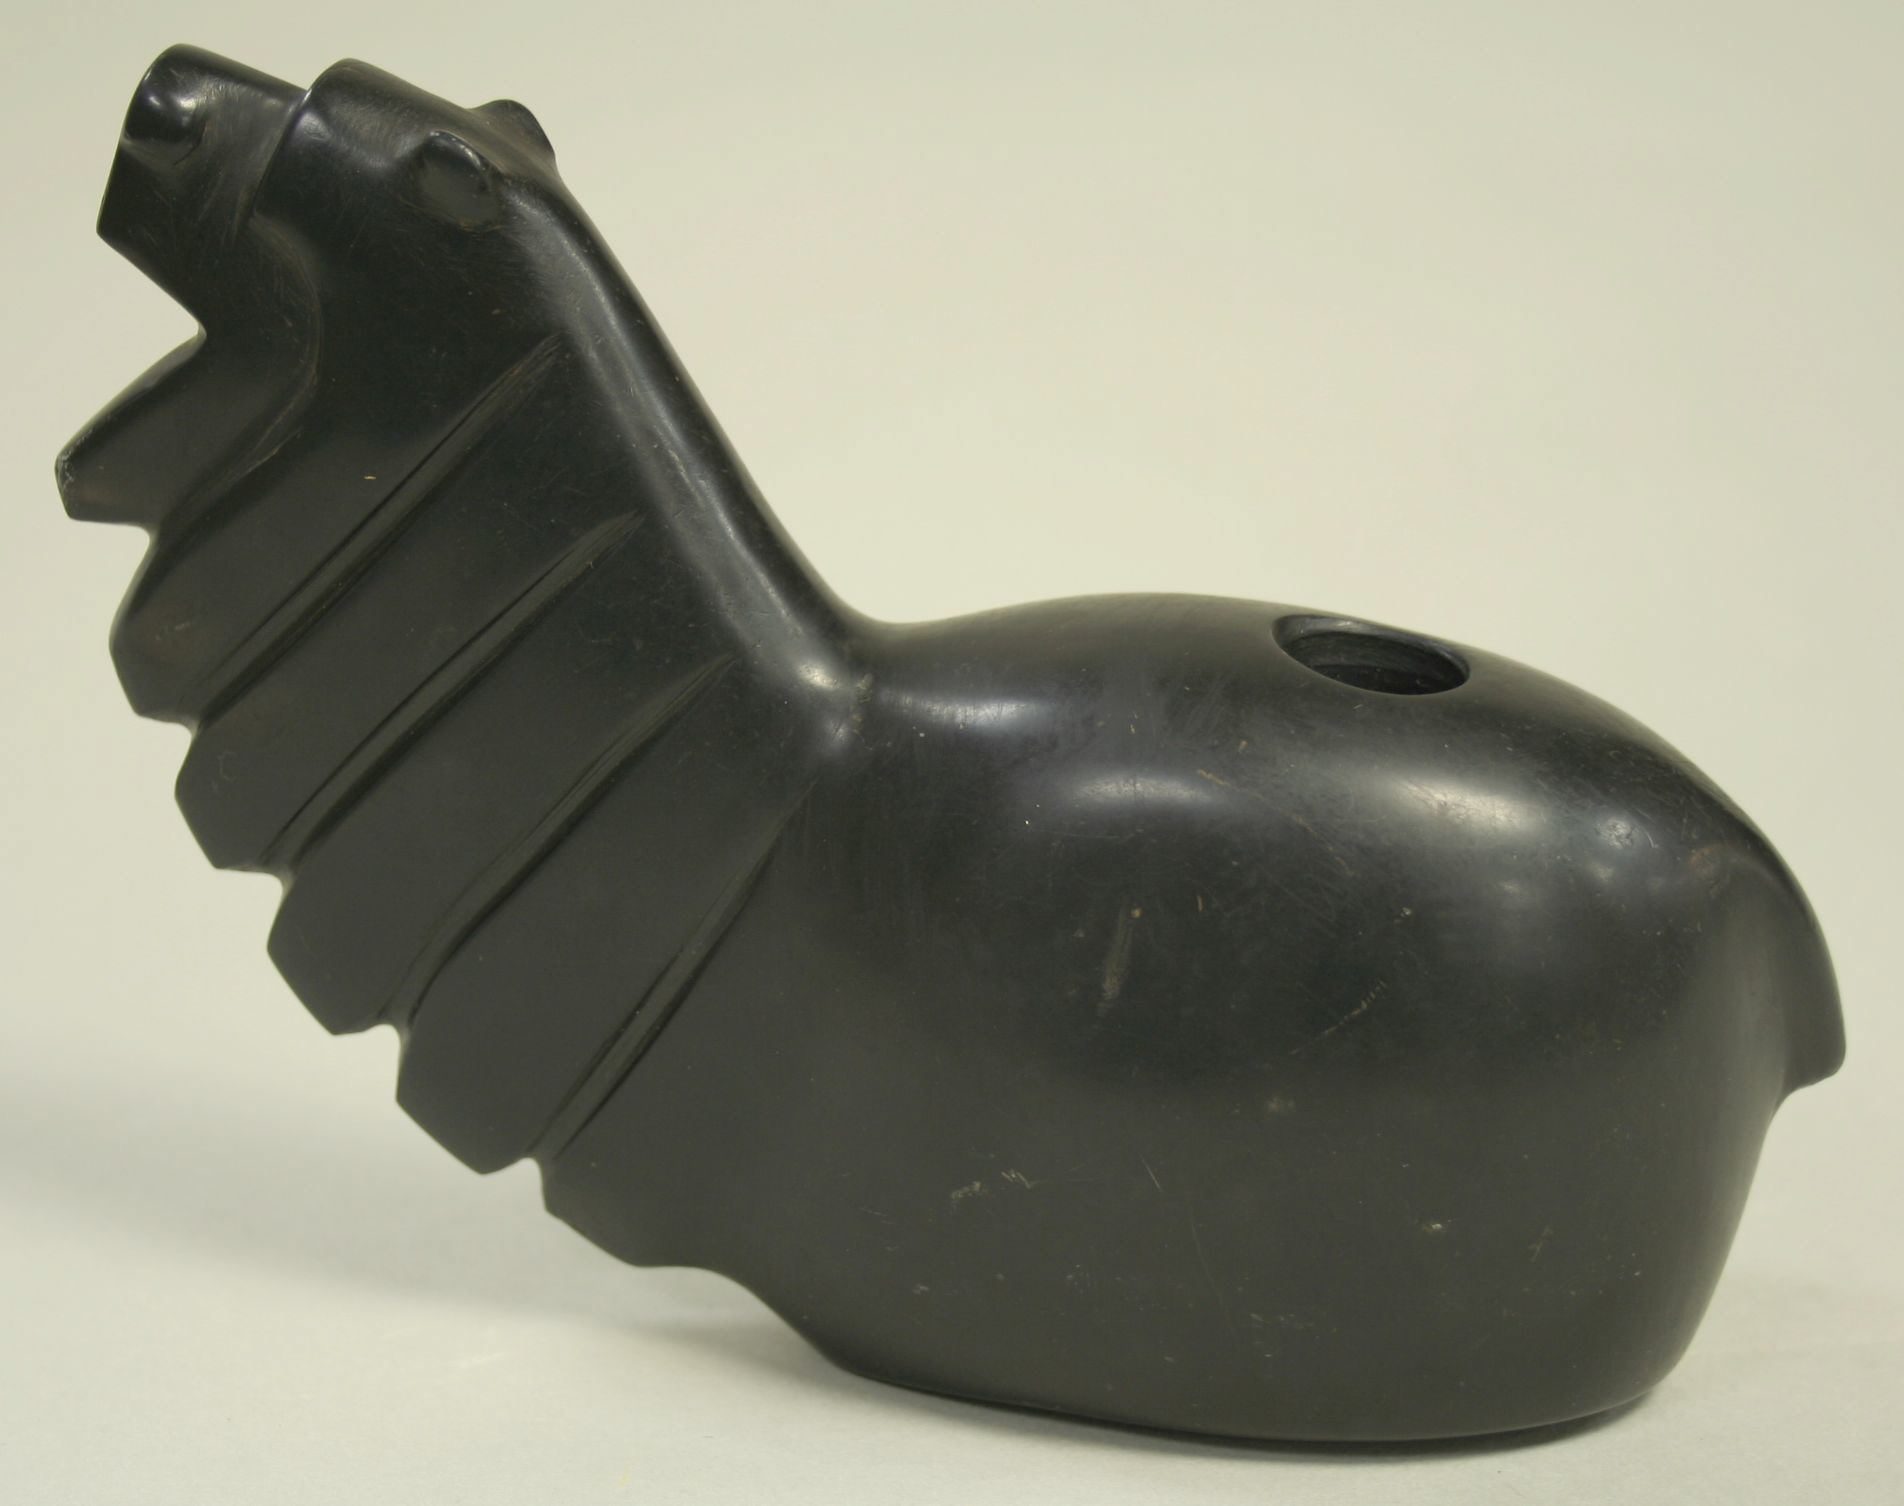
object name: container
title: Votive Container (Canopa)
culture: inca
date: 1401-1500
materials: stone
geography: peru